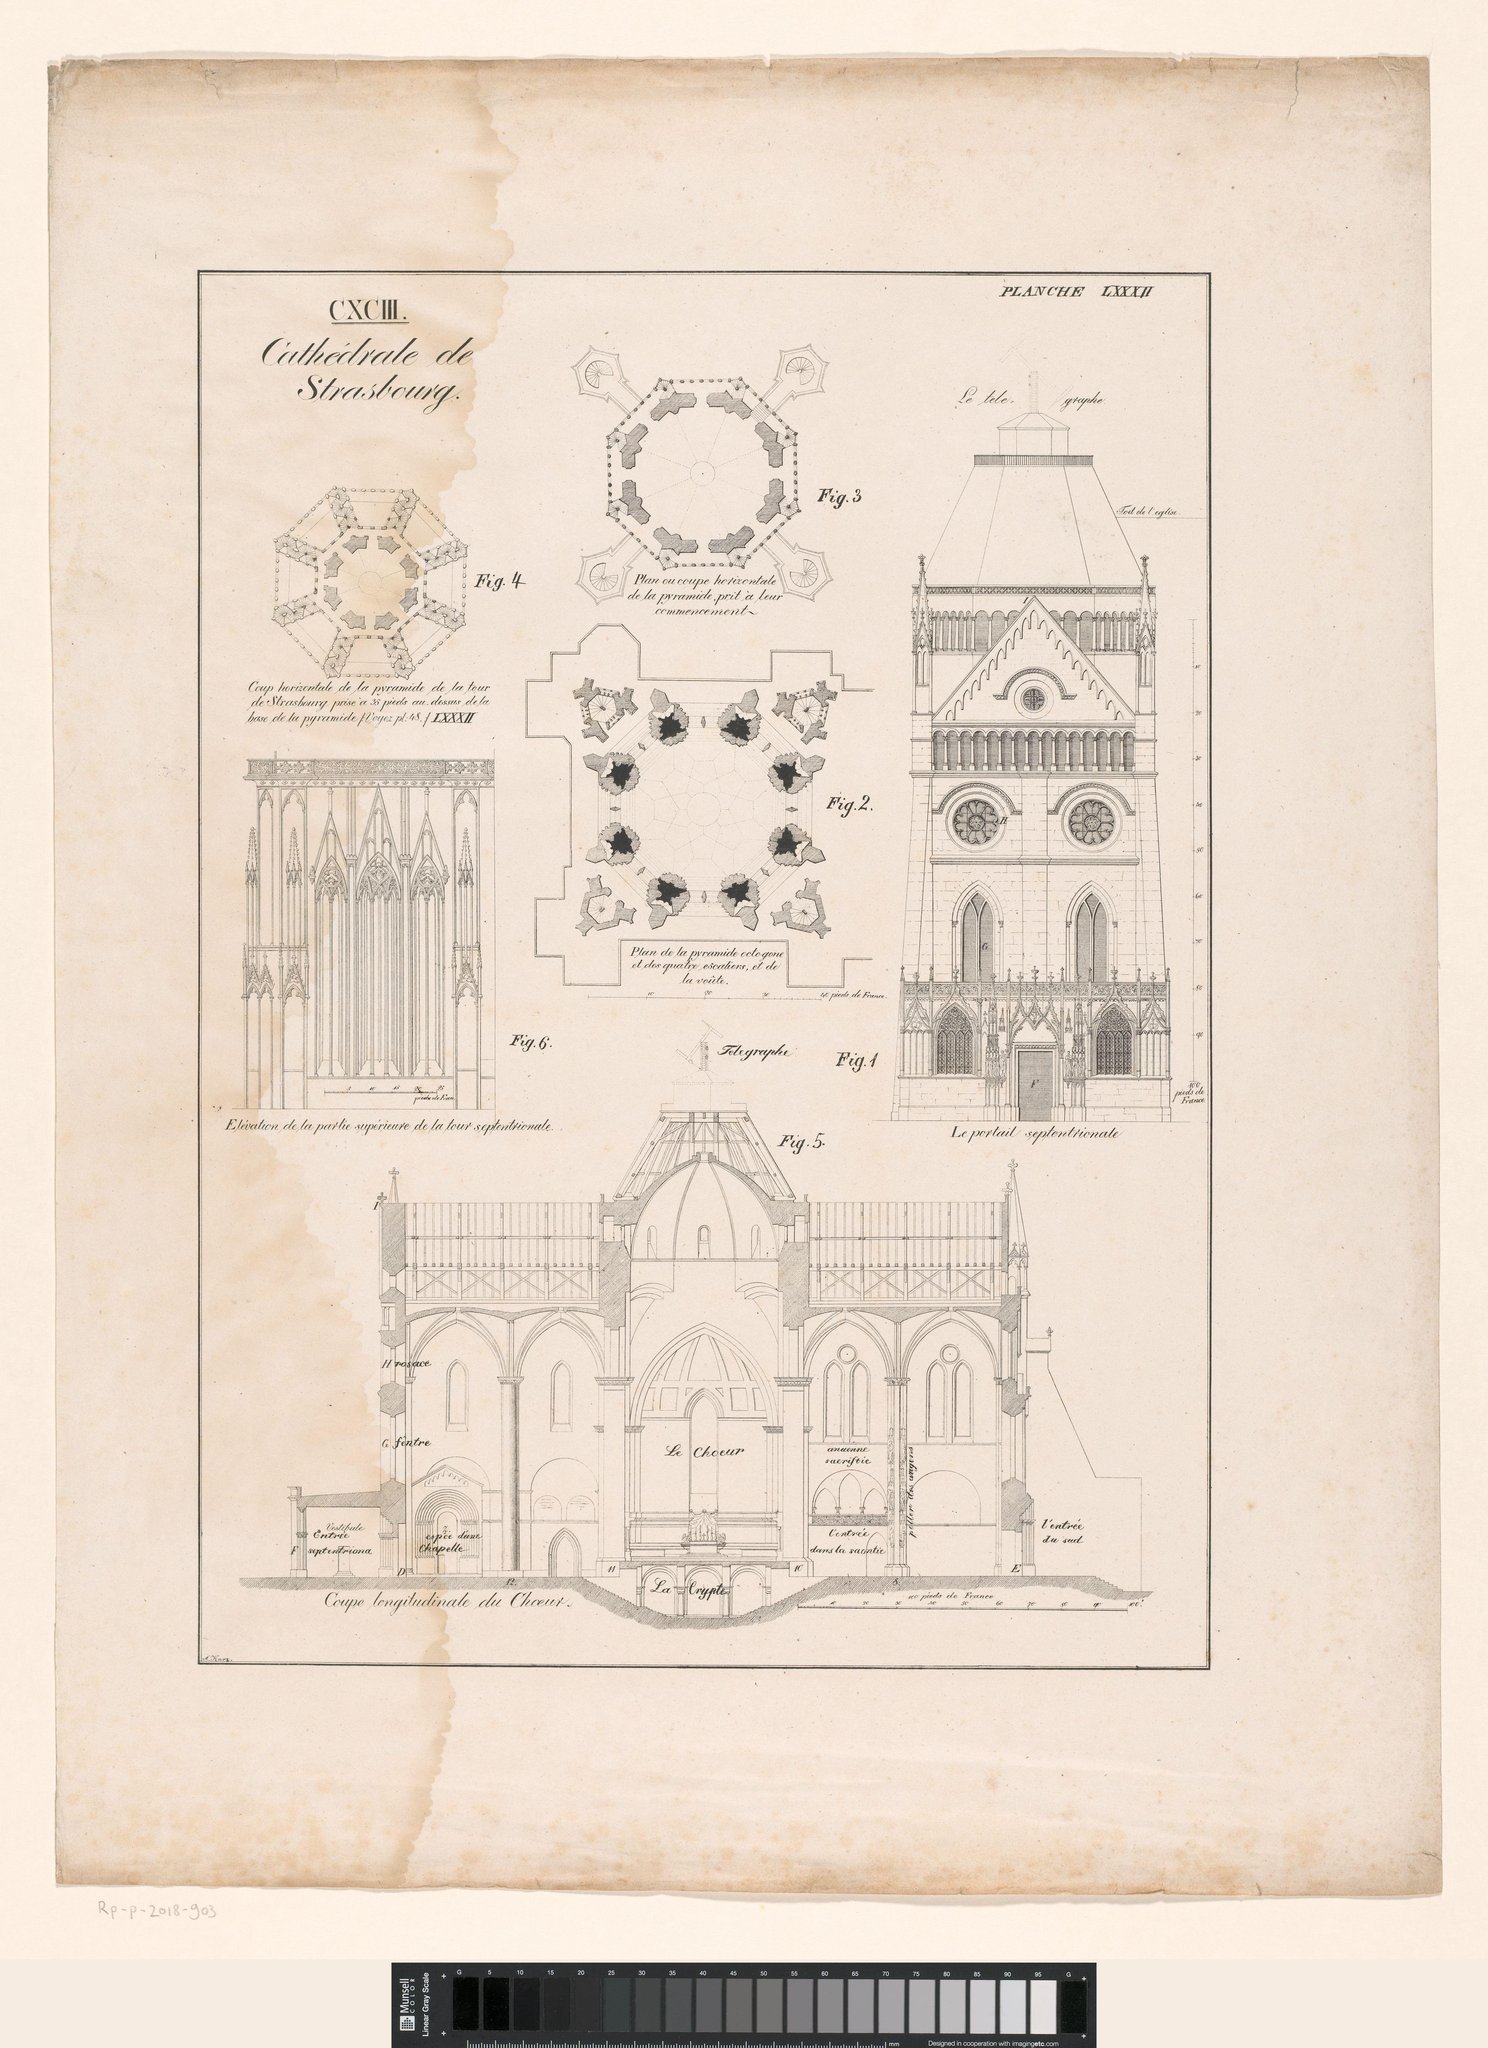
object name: print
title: Verschillende gezichten op en doorsnedes van de kathedraal van Straatsburg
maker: Anonymous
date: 1821-1826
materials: paper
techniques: engraving, etching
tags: church (exterior)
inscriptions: collector's mark: Lugt 2228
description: Prent gebruikt in: Wiebeking, Carl Friedrich von. Theoretische-practische bürgerliche Baukunde (...). München: Lindauerschen Hofbuchdruckerey, 1821-1826.